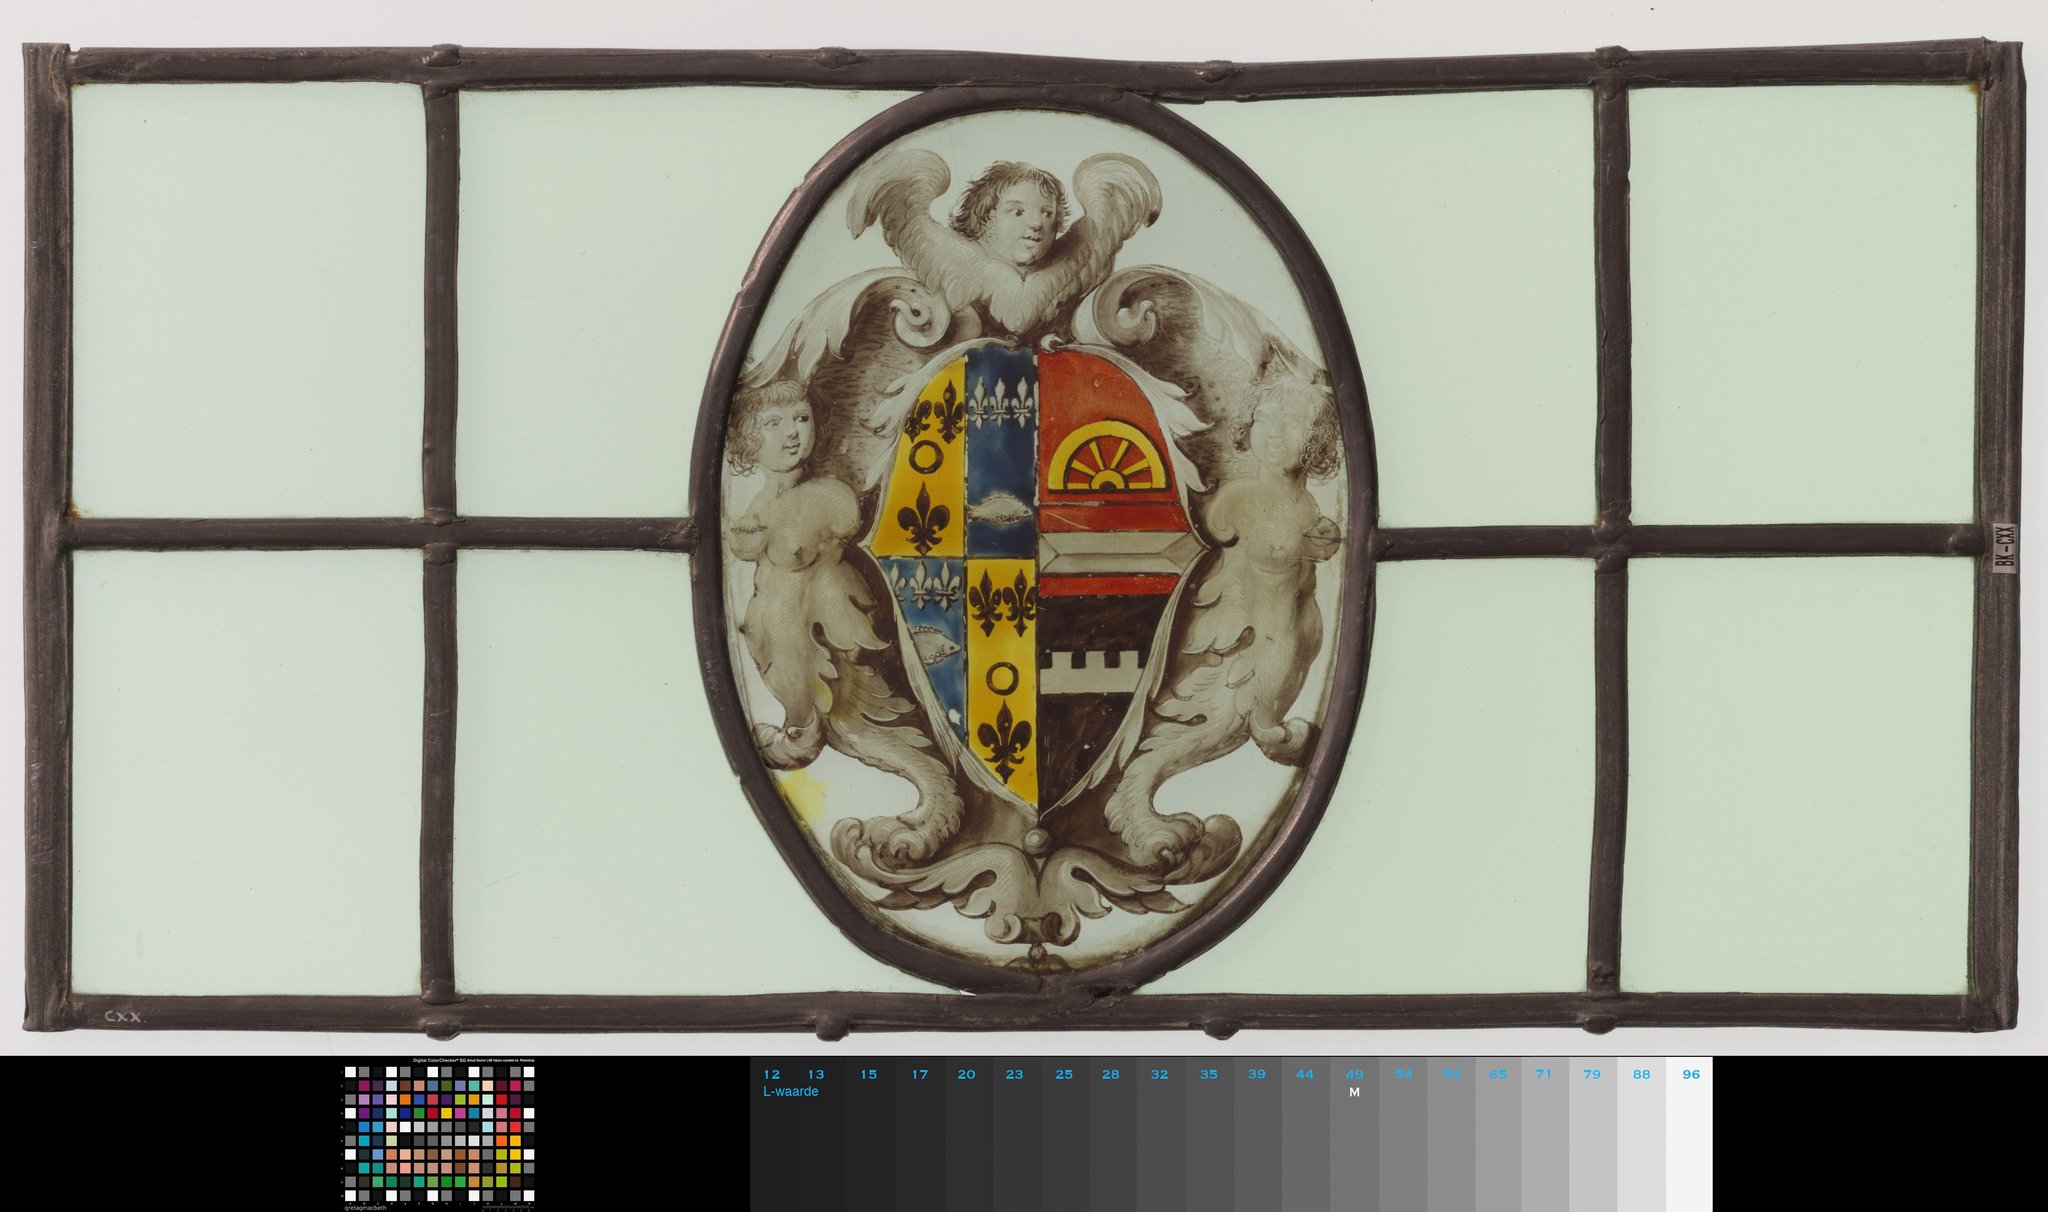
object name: wapenruit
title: Ruit met wapen in cartouche, bekroond door een engel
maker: Anonymous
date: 1700-1800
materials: glass, lead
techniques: leading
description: Ovale geschilderde ruit met wapen omgeven door een cartouche rand " en grisaille" bekroond door een engel.